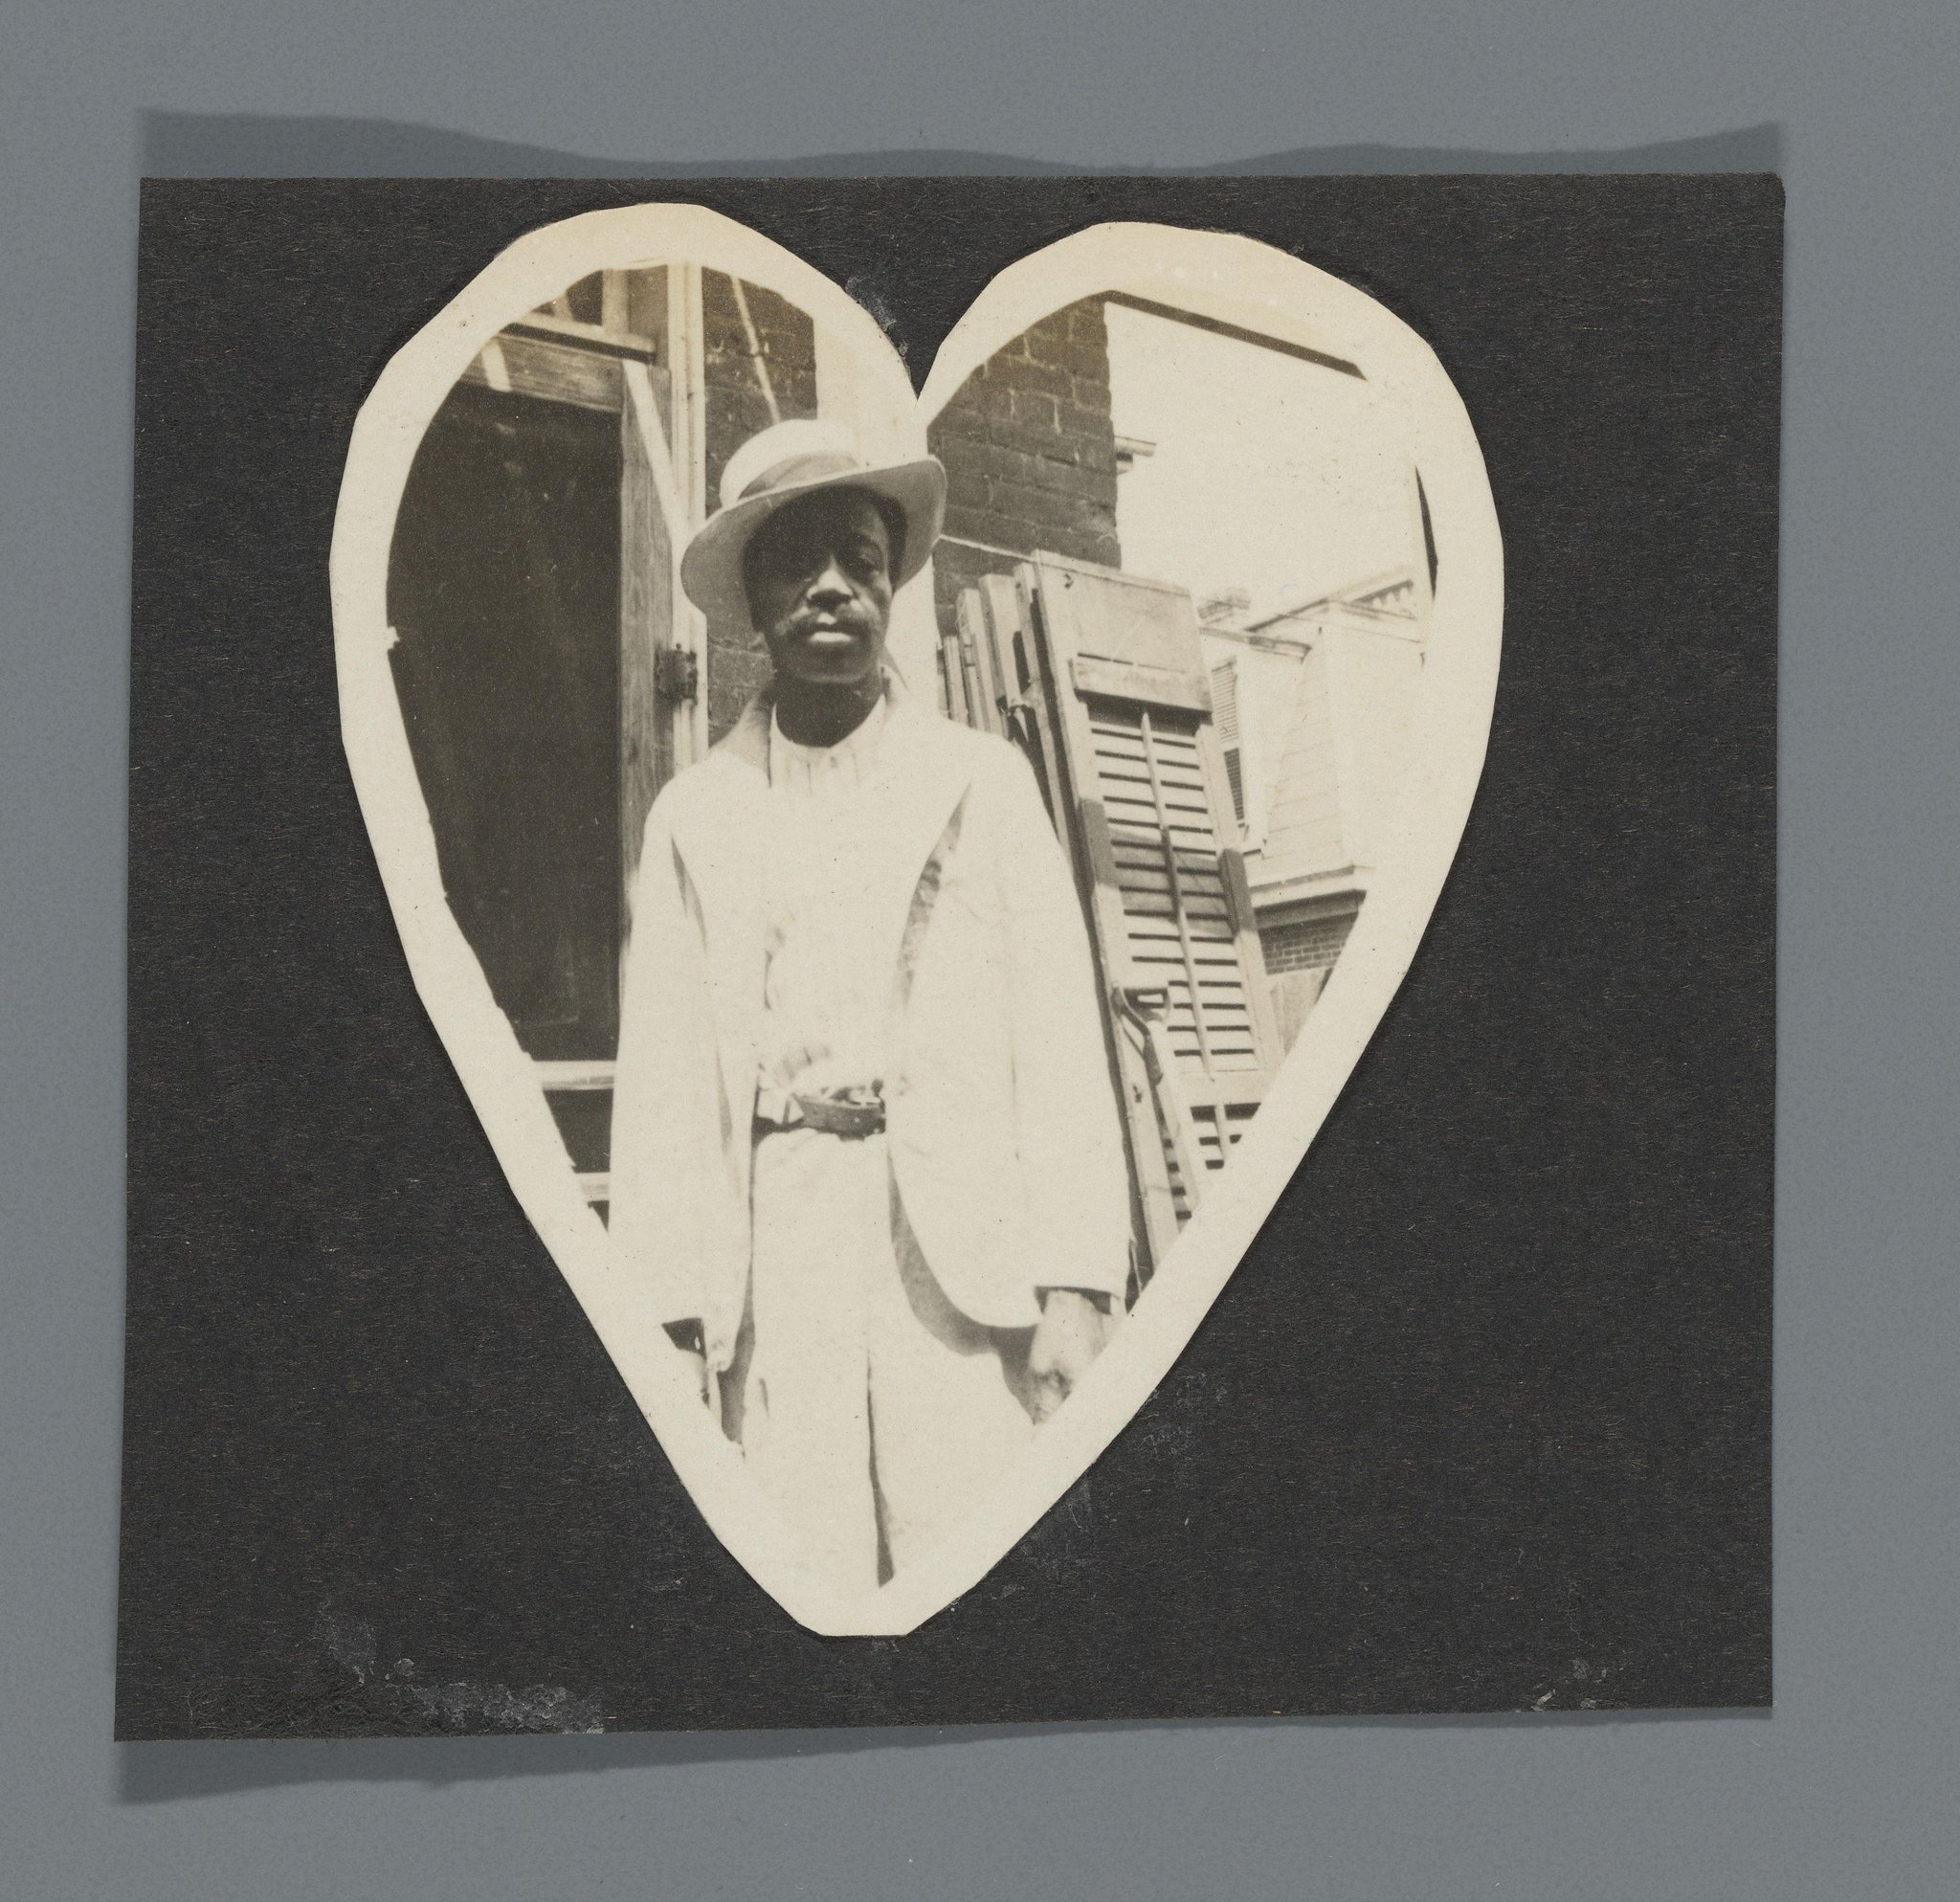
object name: photograph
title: Portret van een African American man, geknipt in een hartvorm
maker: Anonymous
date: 1930-1950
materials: paper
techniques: gelatin silver print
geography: united states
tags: united states of america